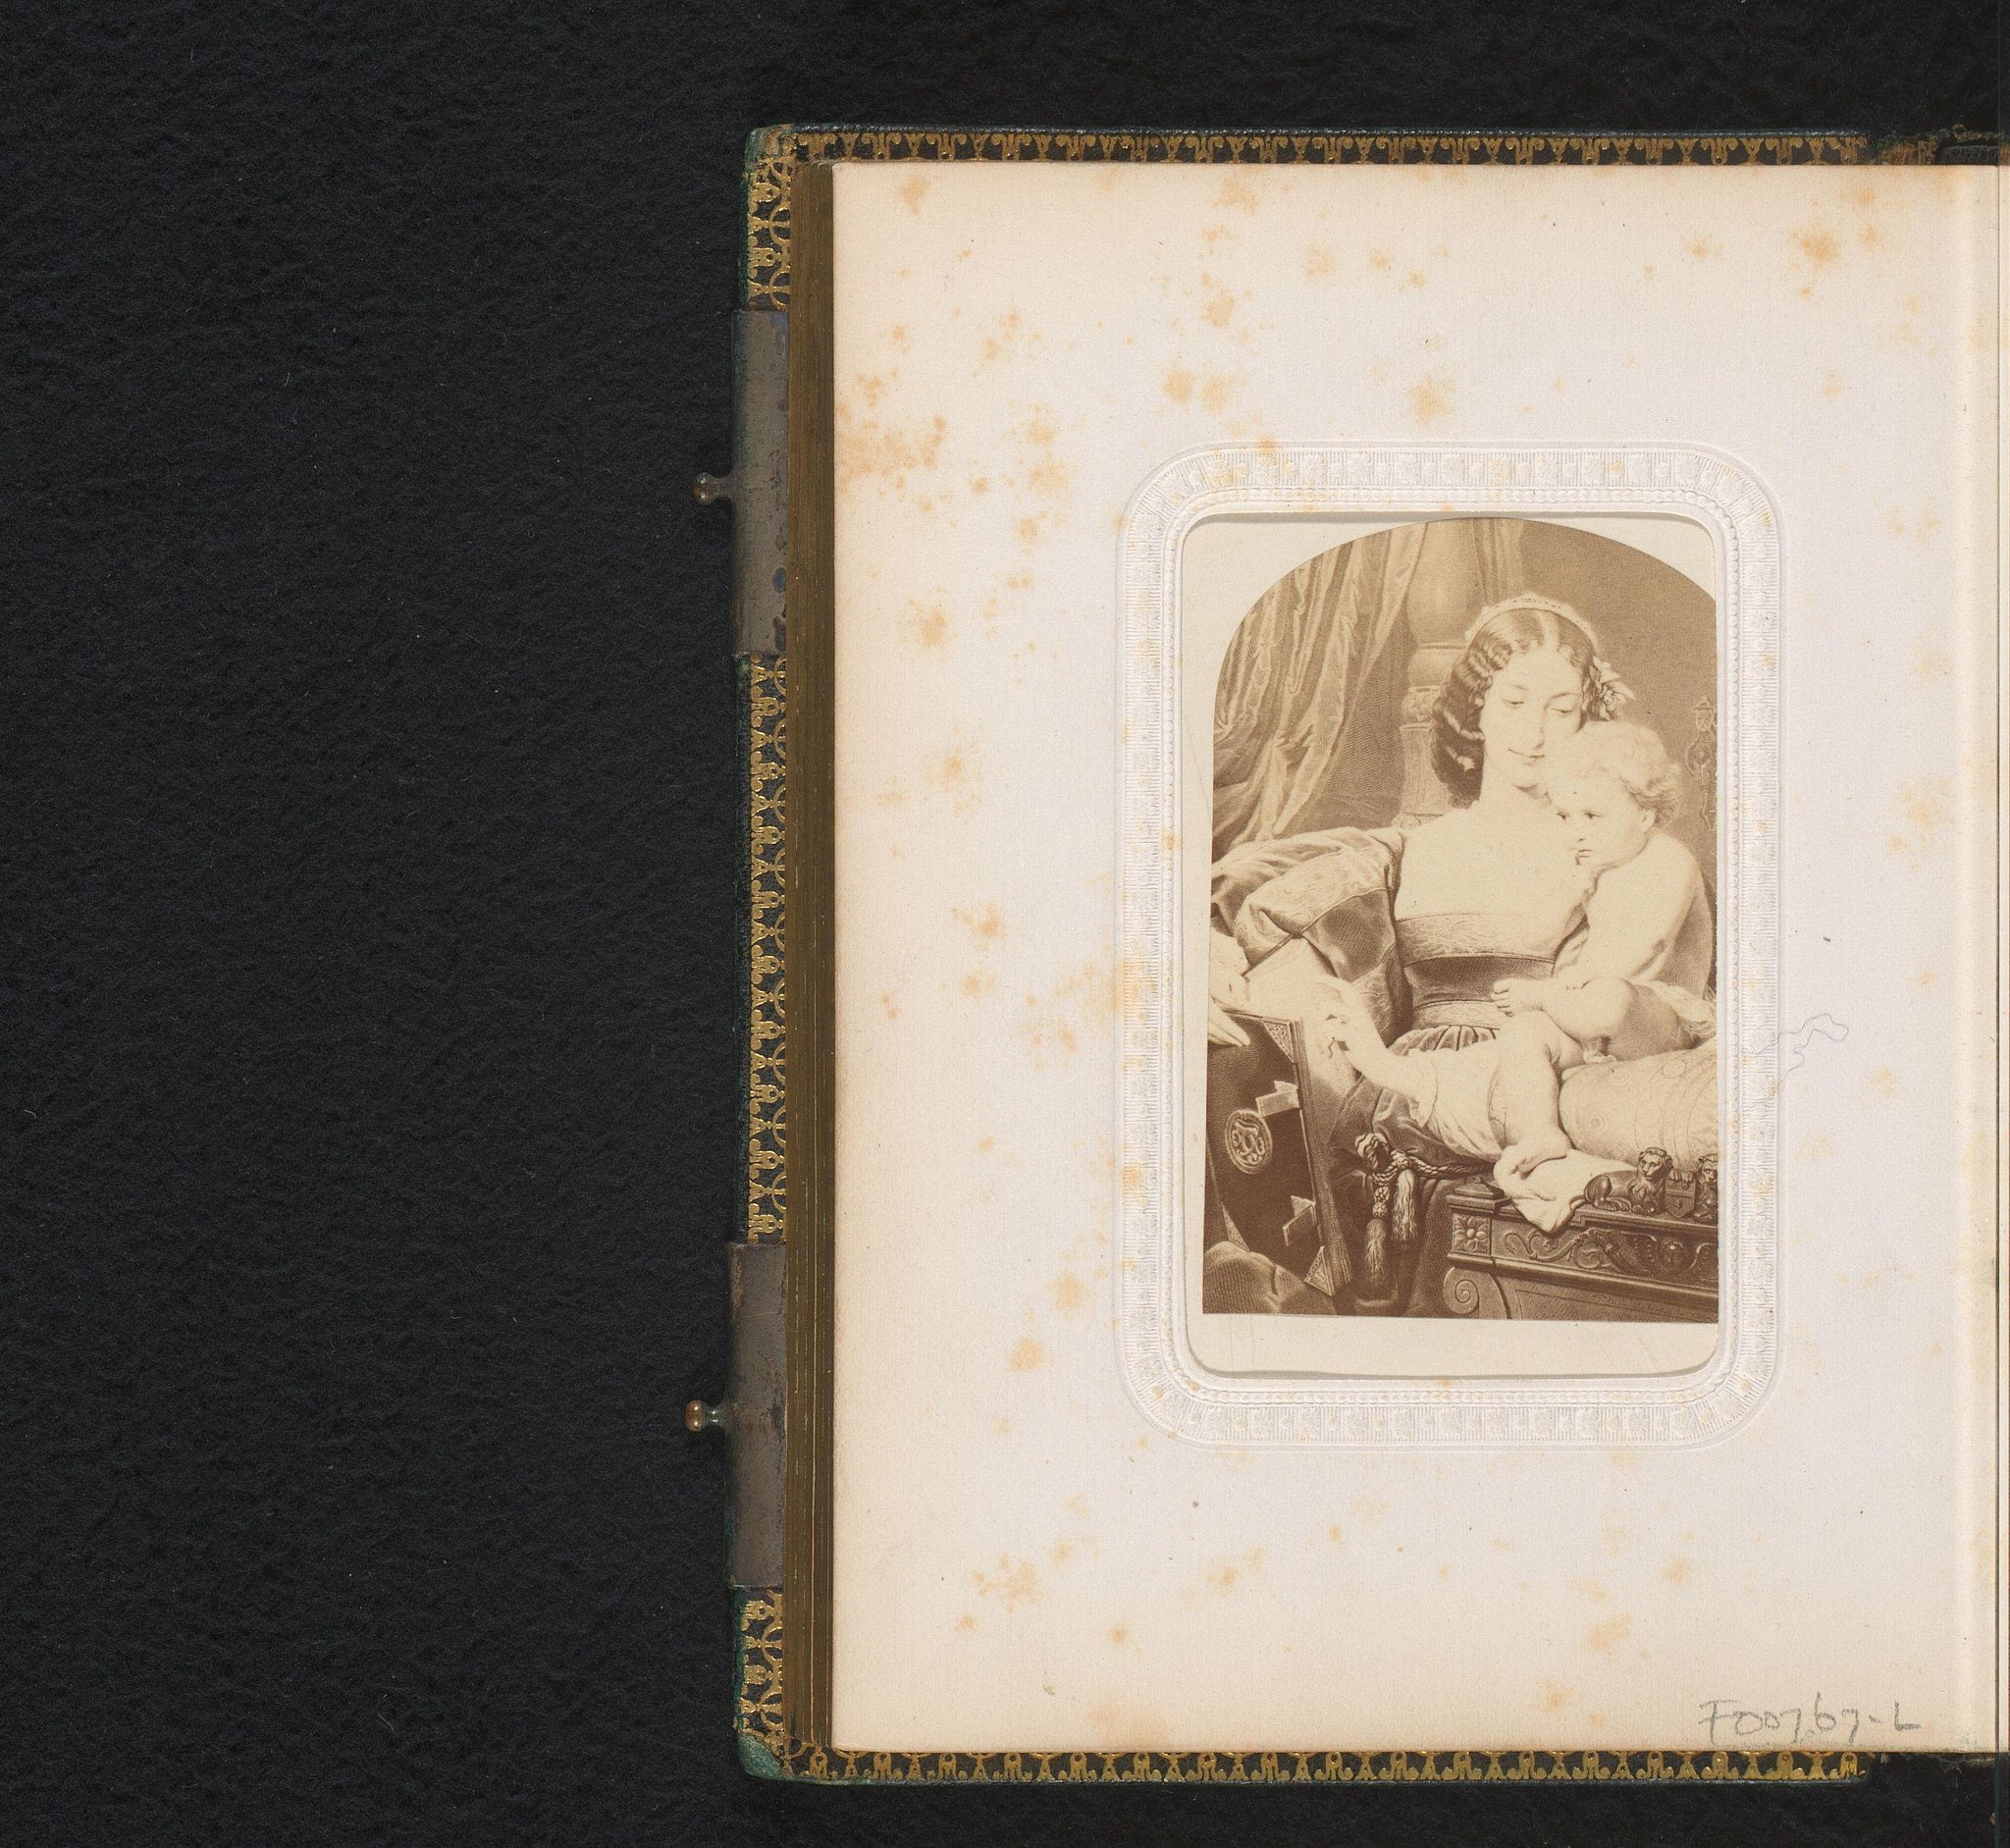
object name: reproduction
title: Fotoreproductie van een schilderij van Giovanni Pico della Mirandola als kind door Paul Delaroche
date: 1861-1878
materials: cardboard, photographic support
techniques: albumen print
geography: paris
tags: historical persons, toddler (male), reading to somebody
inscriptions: inscription: ‘PHOTOGRAPHIE GOUPIL & Cie/ PARIS, 19, Bd Montmartre./ LONDRES-LA HAYE-BERLIN-NEW YORK’